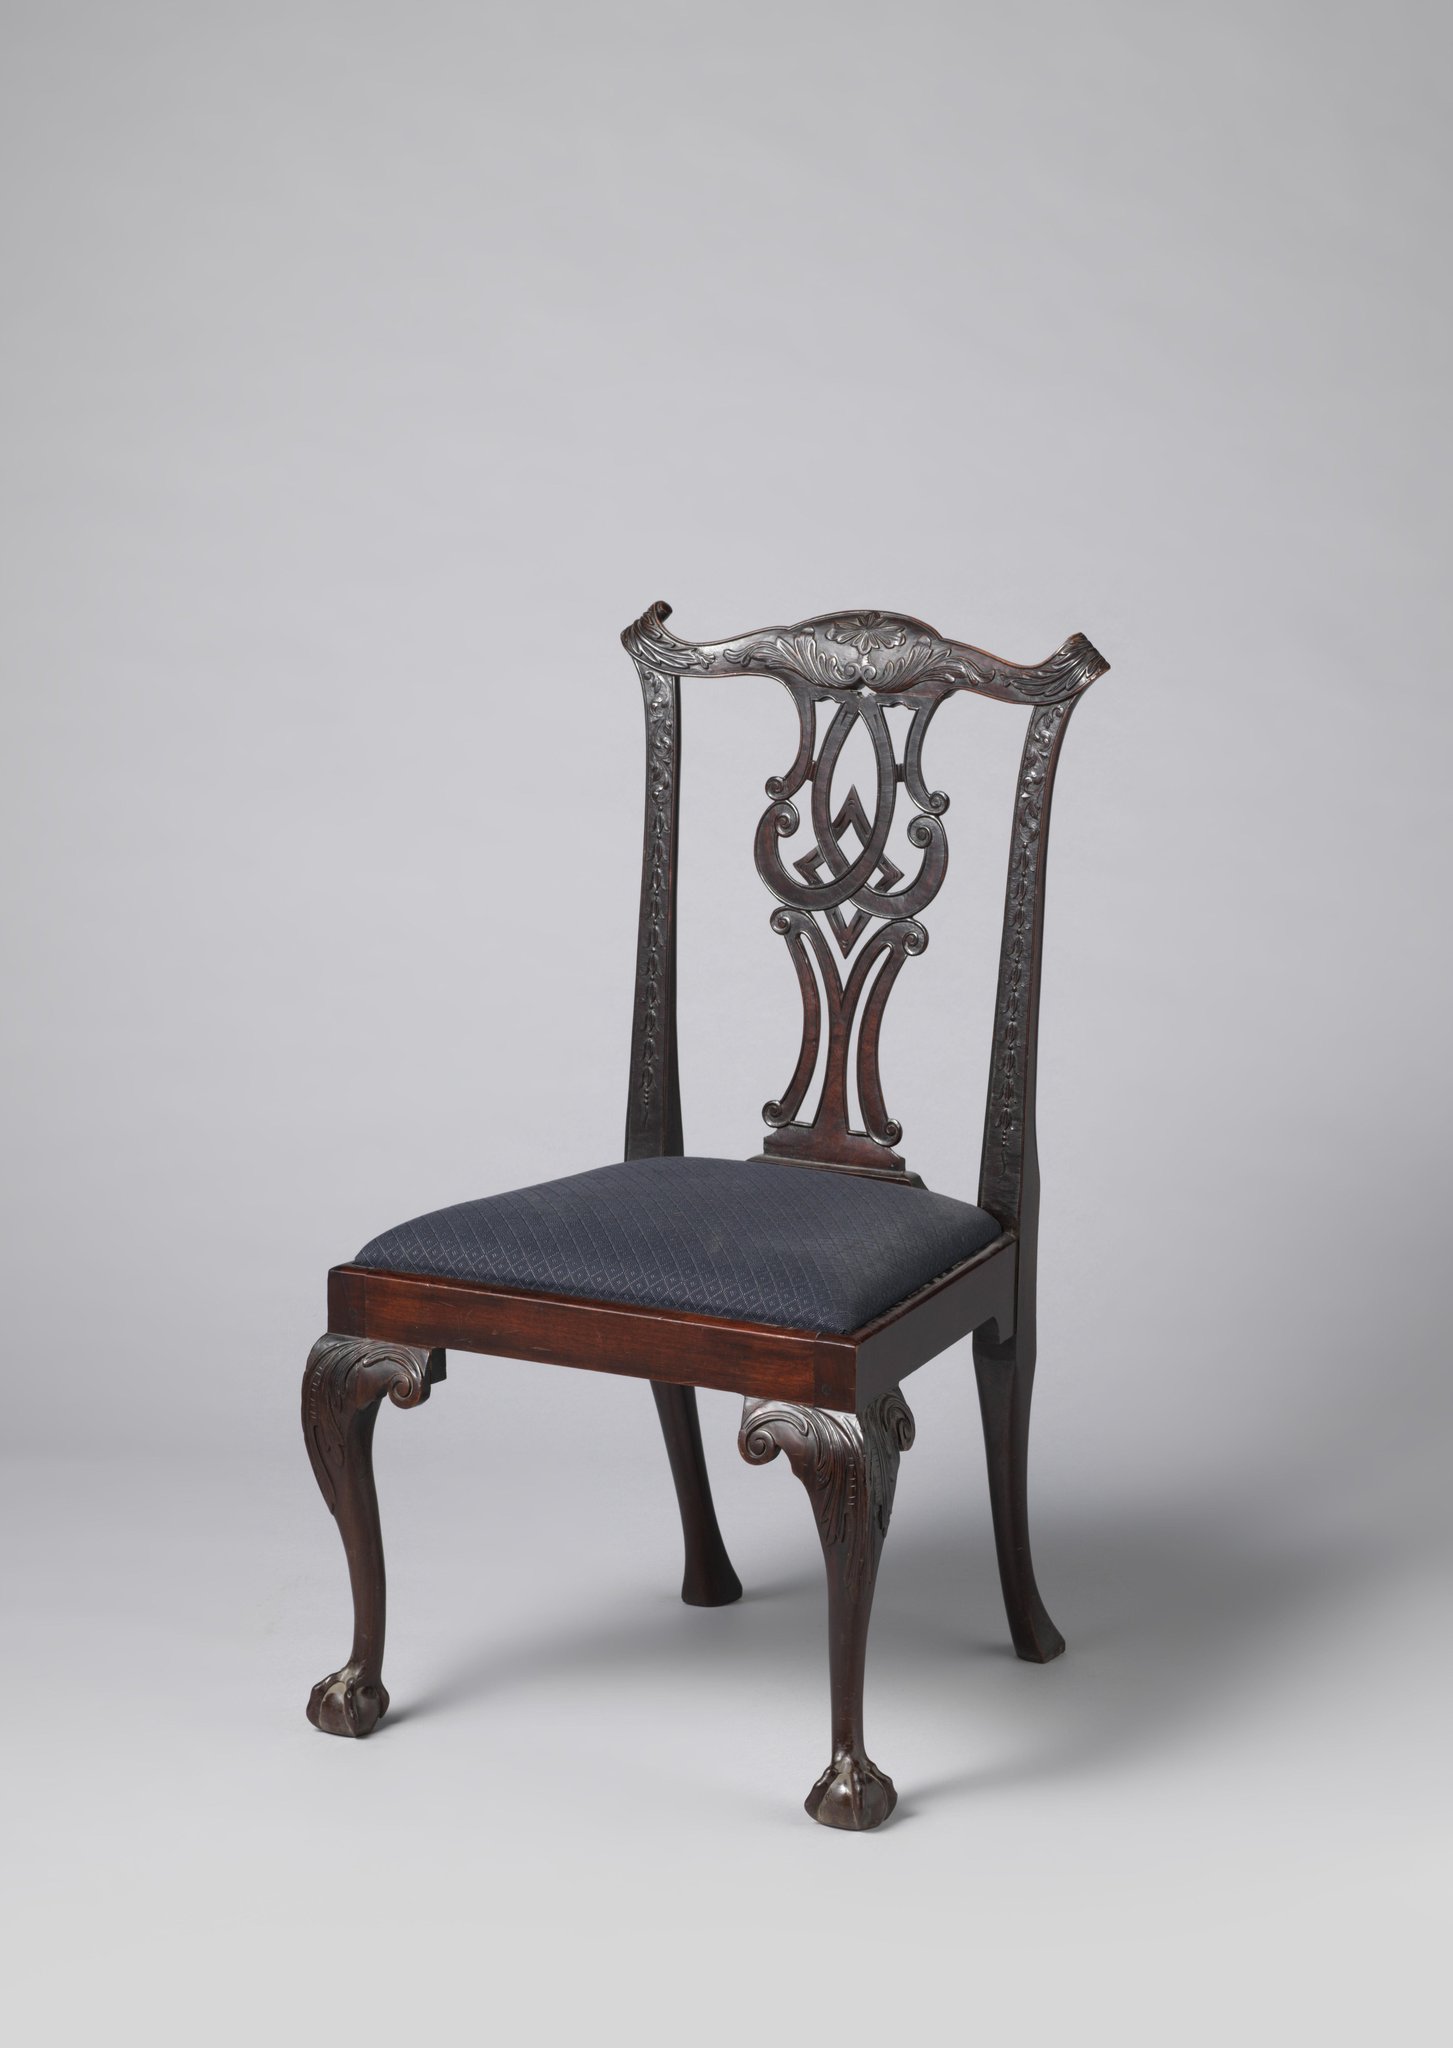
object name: seating furniture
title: Meubilair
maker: Anonymous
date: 1700-1800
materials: leather, wood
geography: great britain